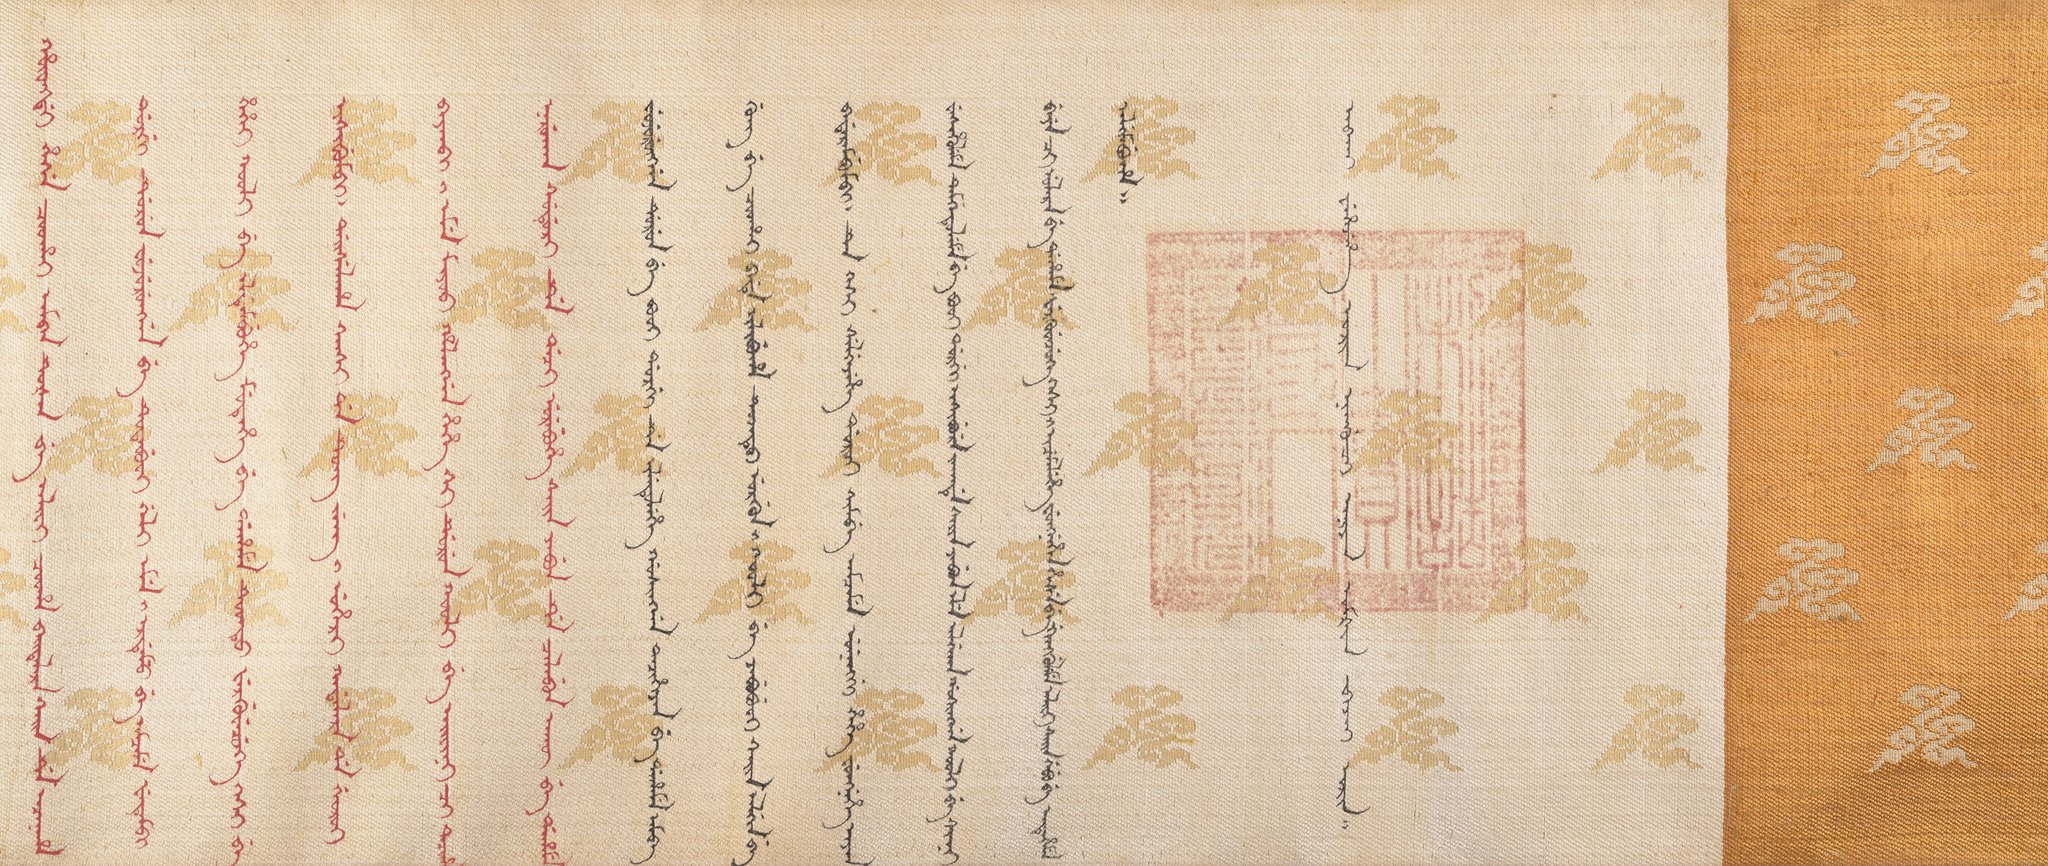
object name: handscroll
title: Rank patent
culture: chinese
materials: ink, paper, silk